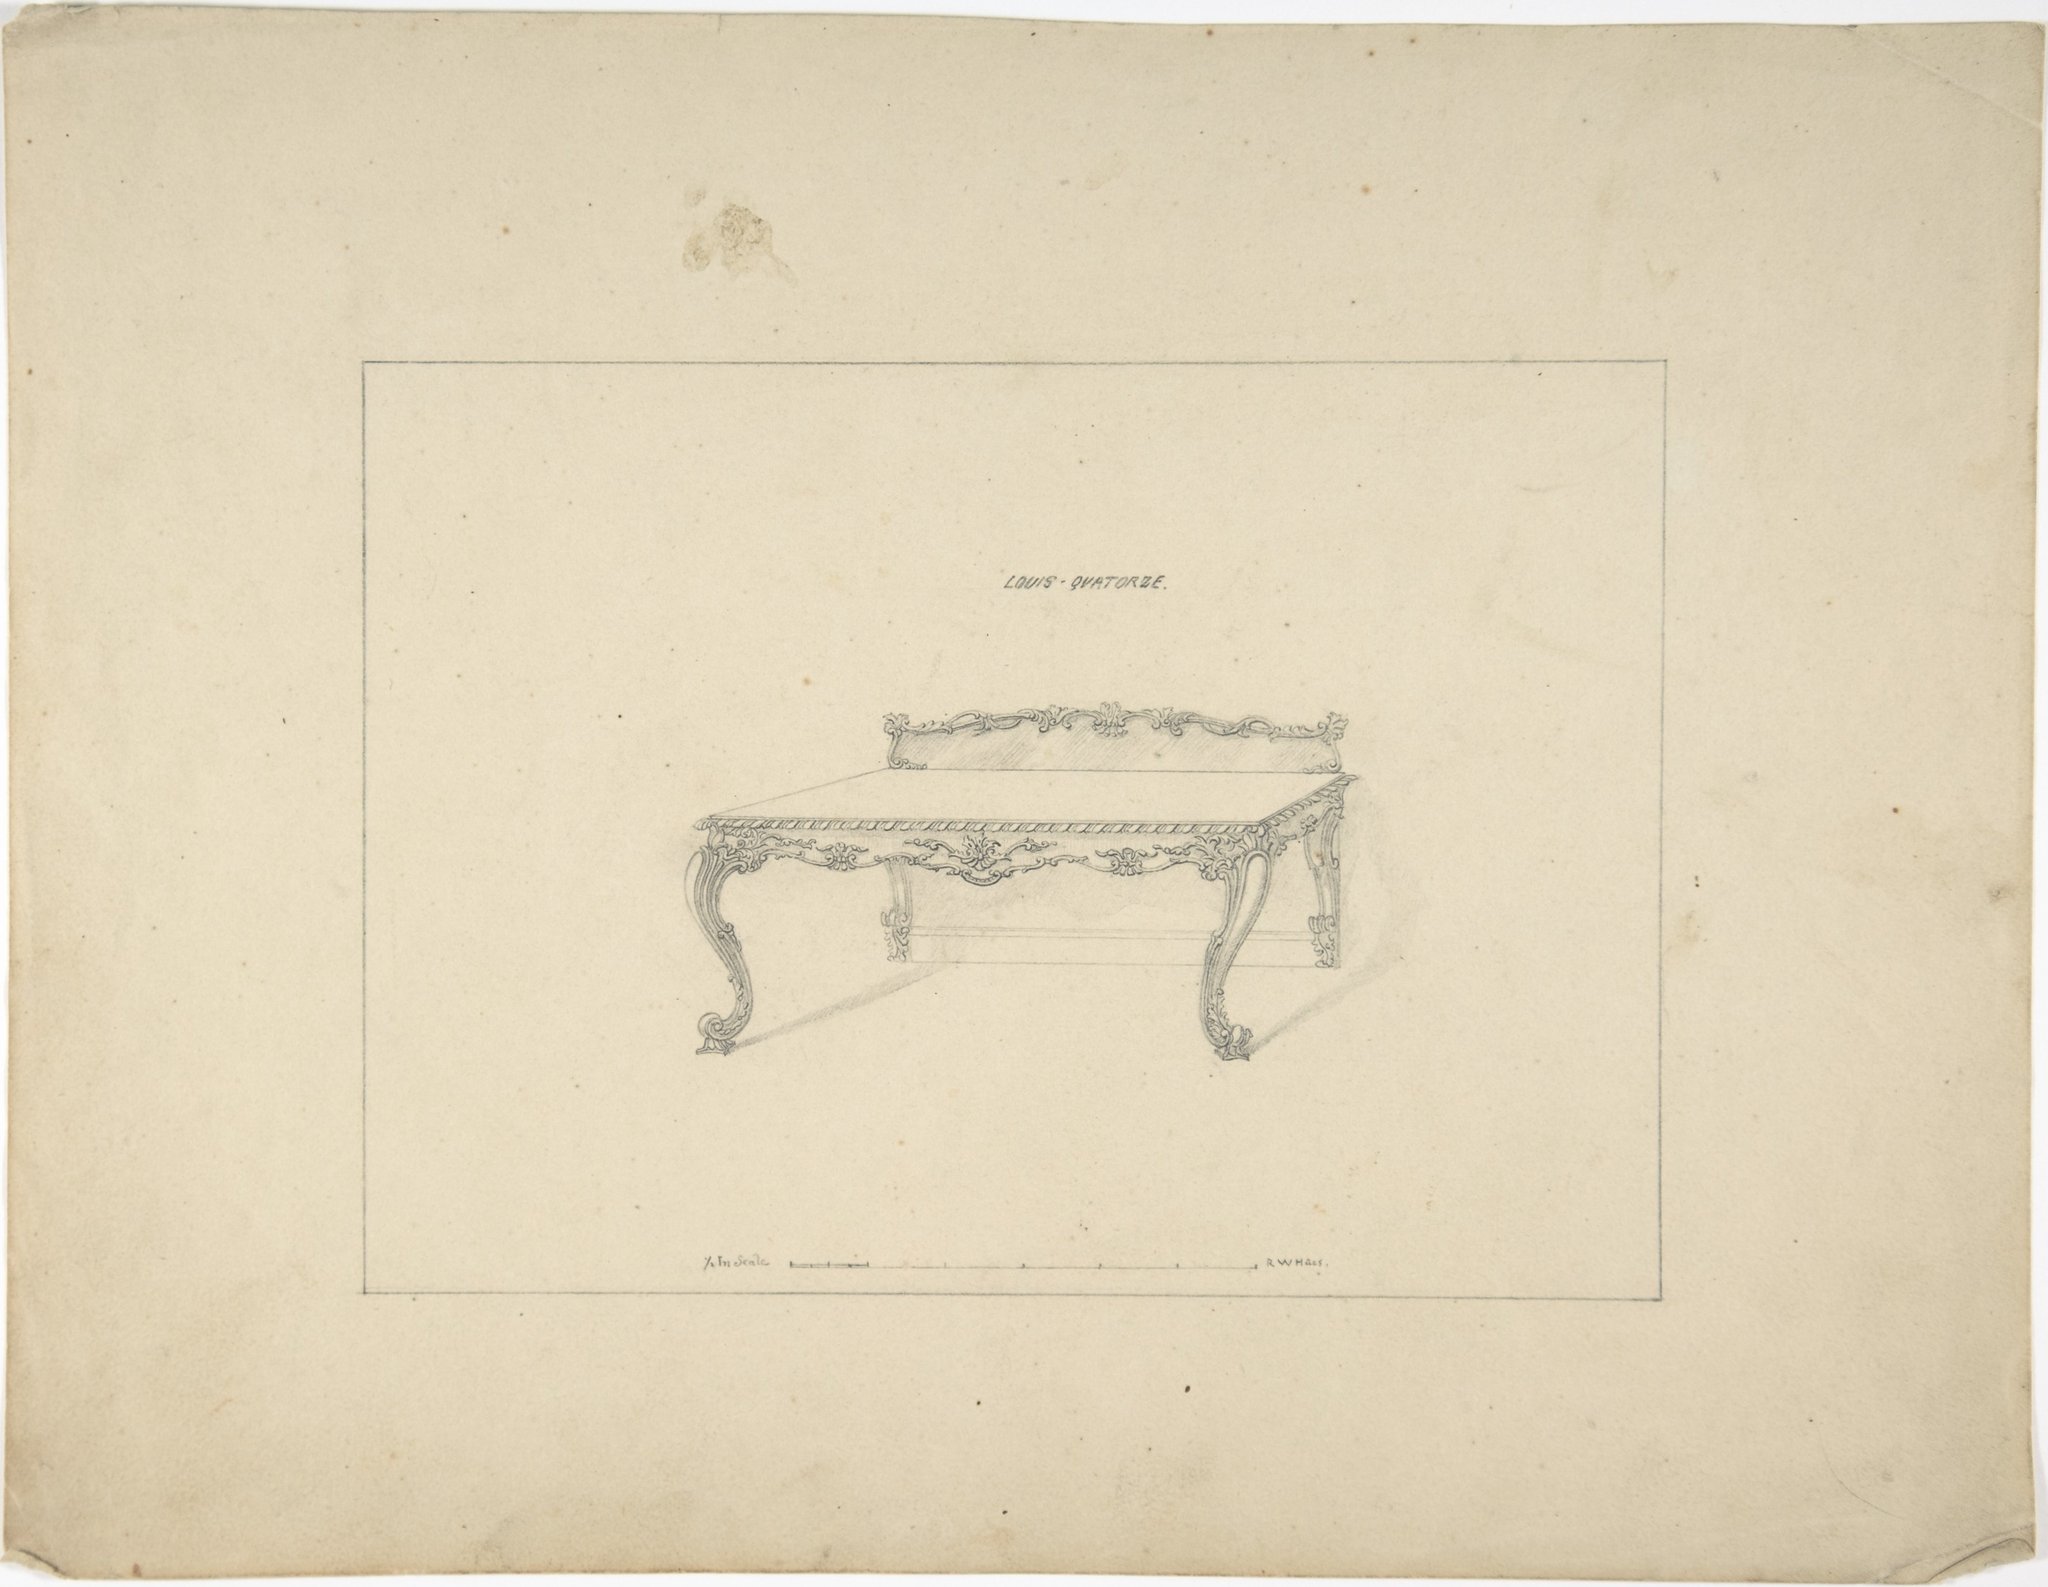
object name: drawing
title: Design for a Sidetable, Louis Quatorze Style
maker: robert william hume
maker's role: artist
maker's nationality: british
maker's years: 1816-1904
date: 1835-1900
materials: graphite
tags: tables